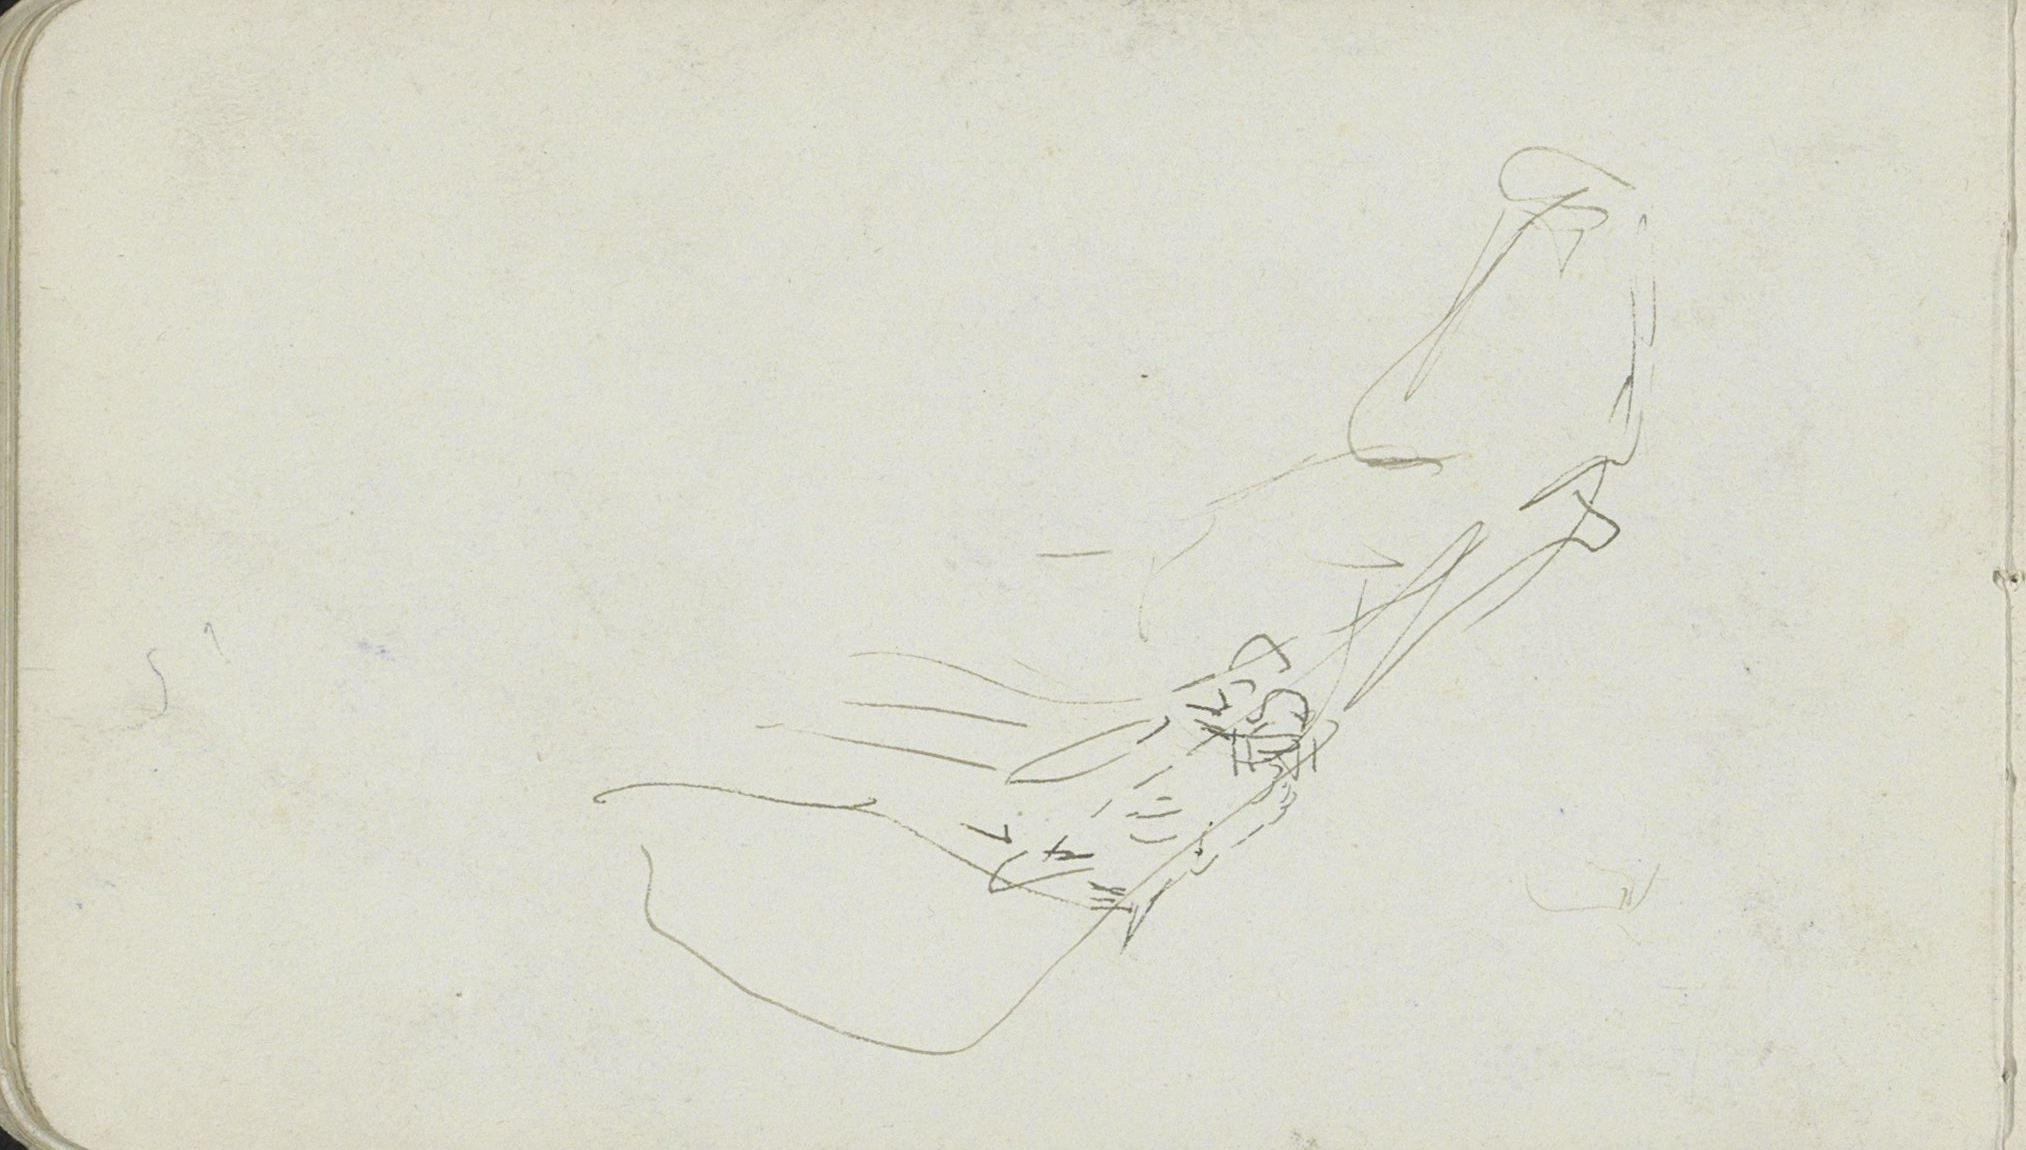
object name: sketchbook leaf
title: Studie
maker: carel adolph lion cachet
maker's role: draughtsman, print maker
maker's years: 1864-1945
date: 1905-1906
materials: ink, paper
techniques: pen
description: Blad 32 verso uit een schetsboek met 34 bladen.